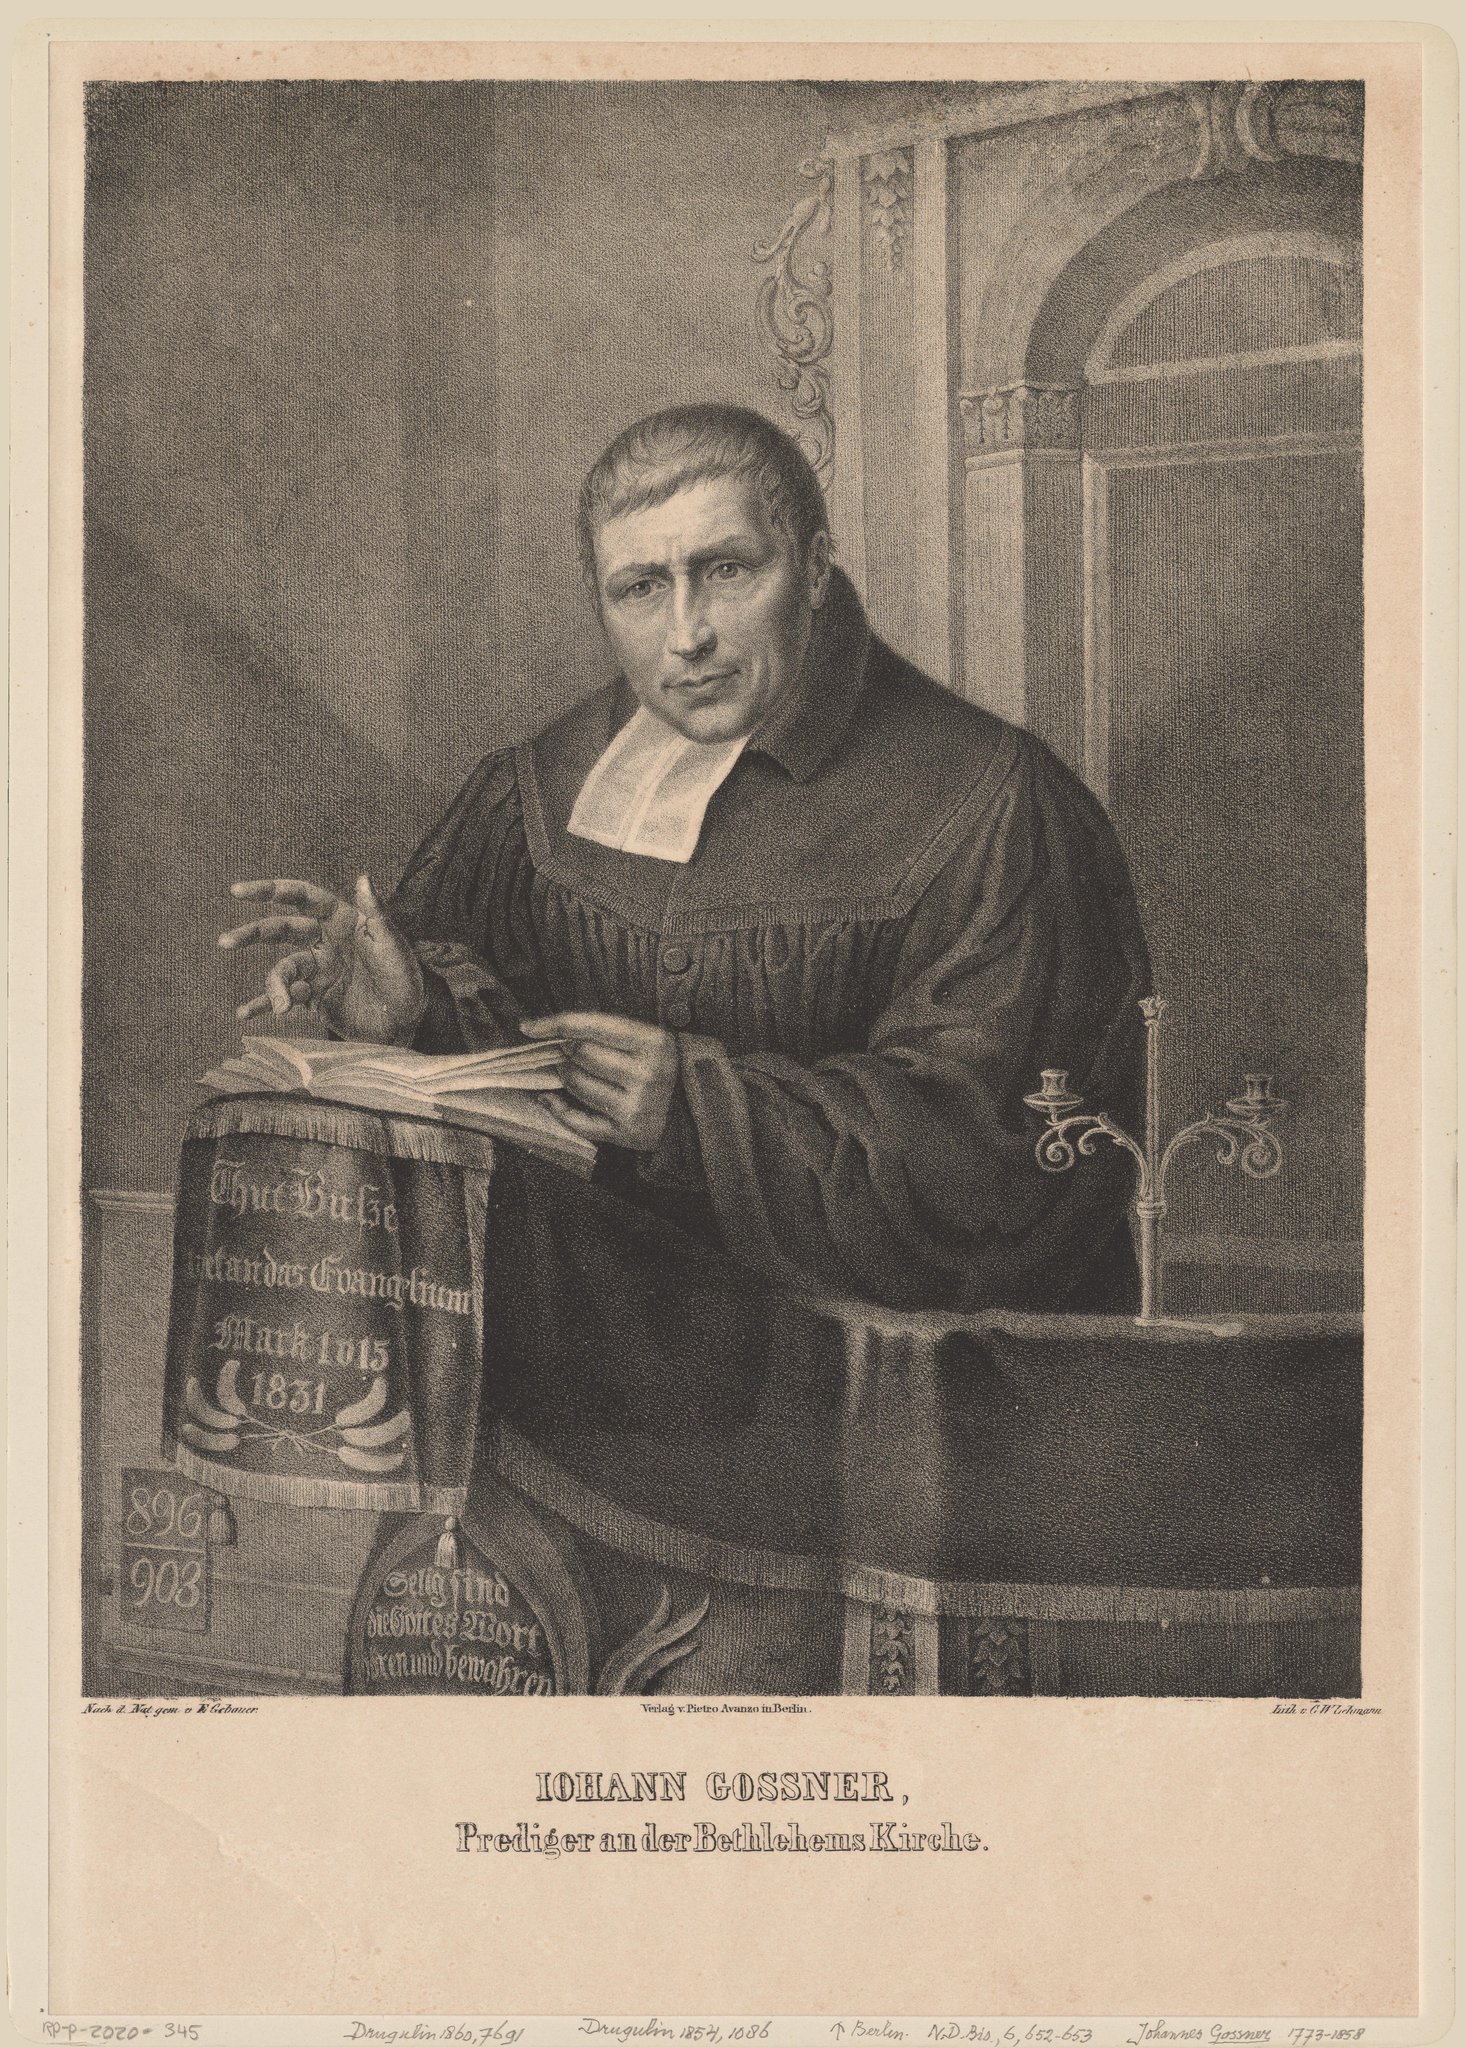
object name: print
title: Portret van Johann Gossner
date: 1788-1860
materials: paper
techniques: lithograph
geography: berlin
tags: berlin, theologian, historical persons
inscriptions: collector's mark: Lugt 2228